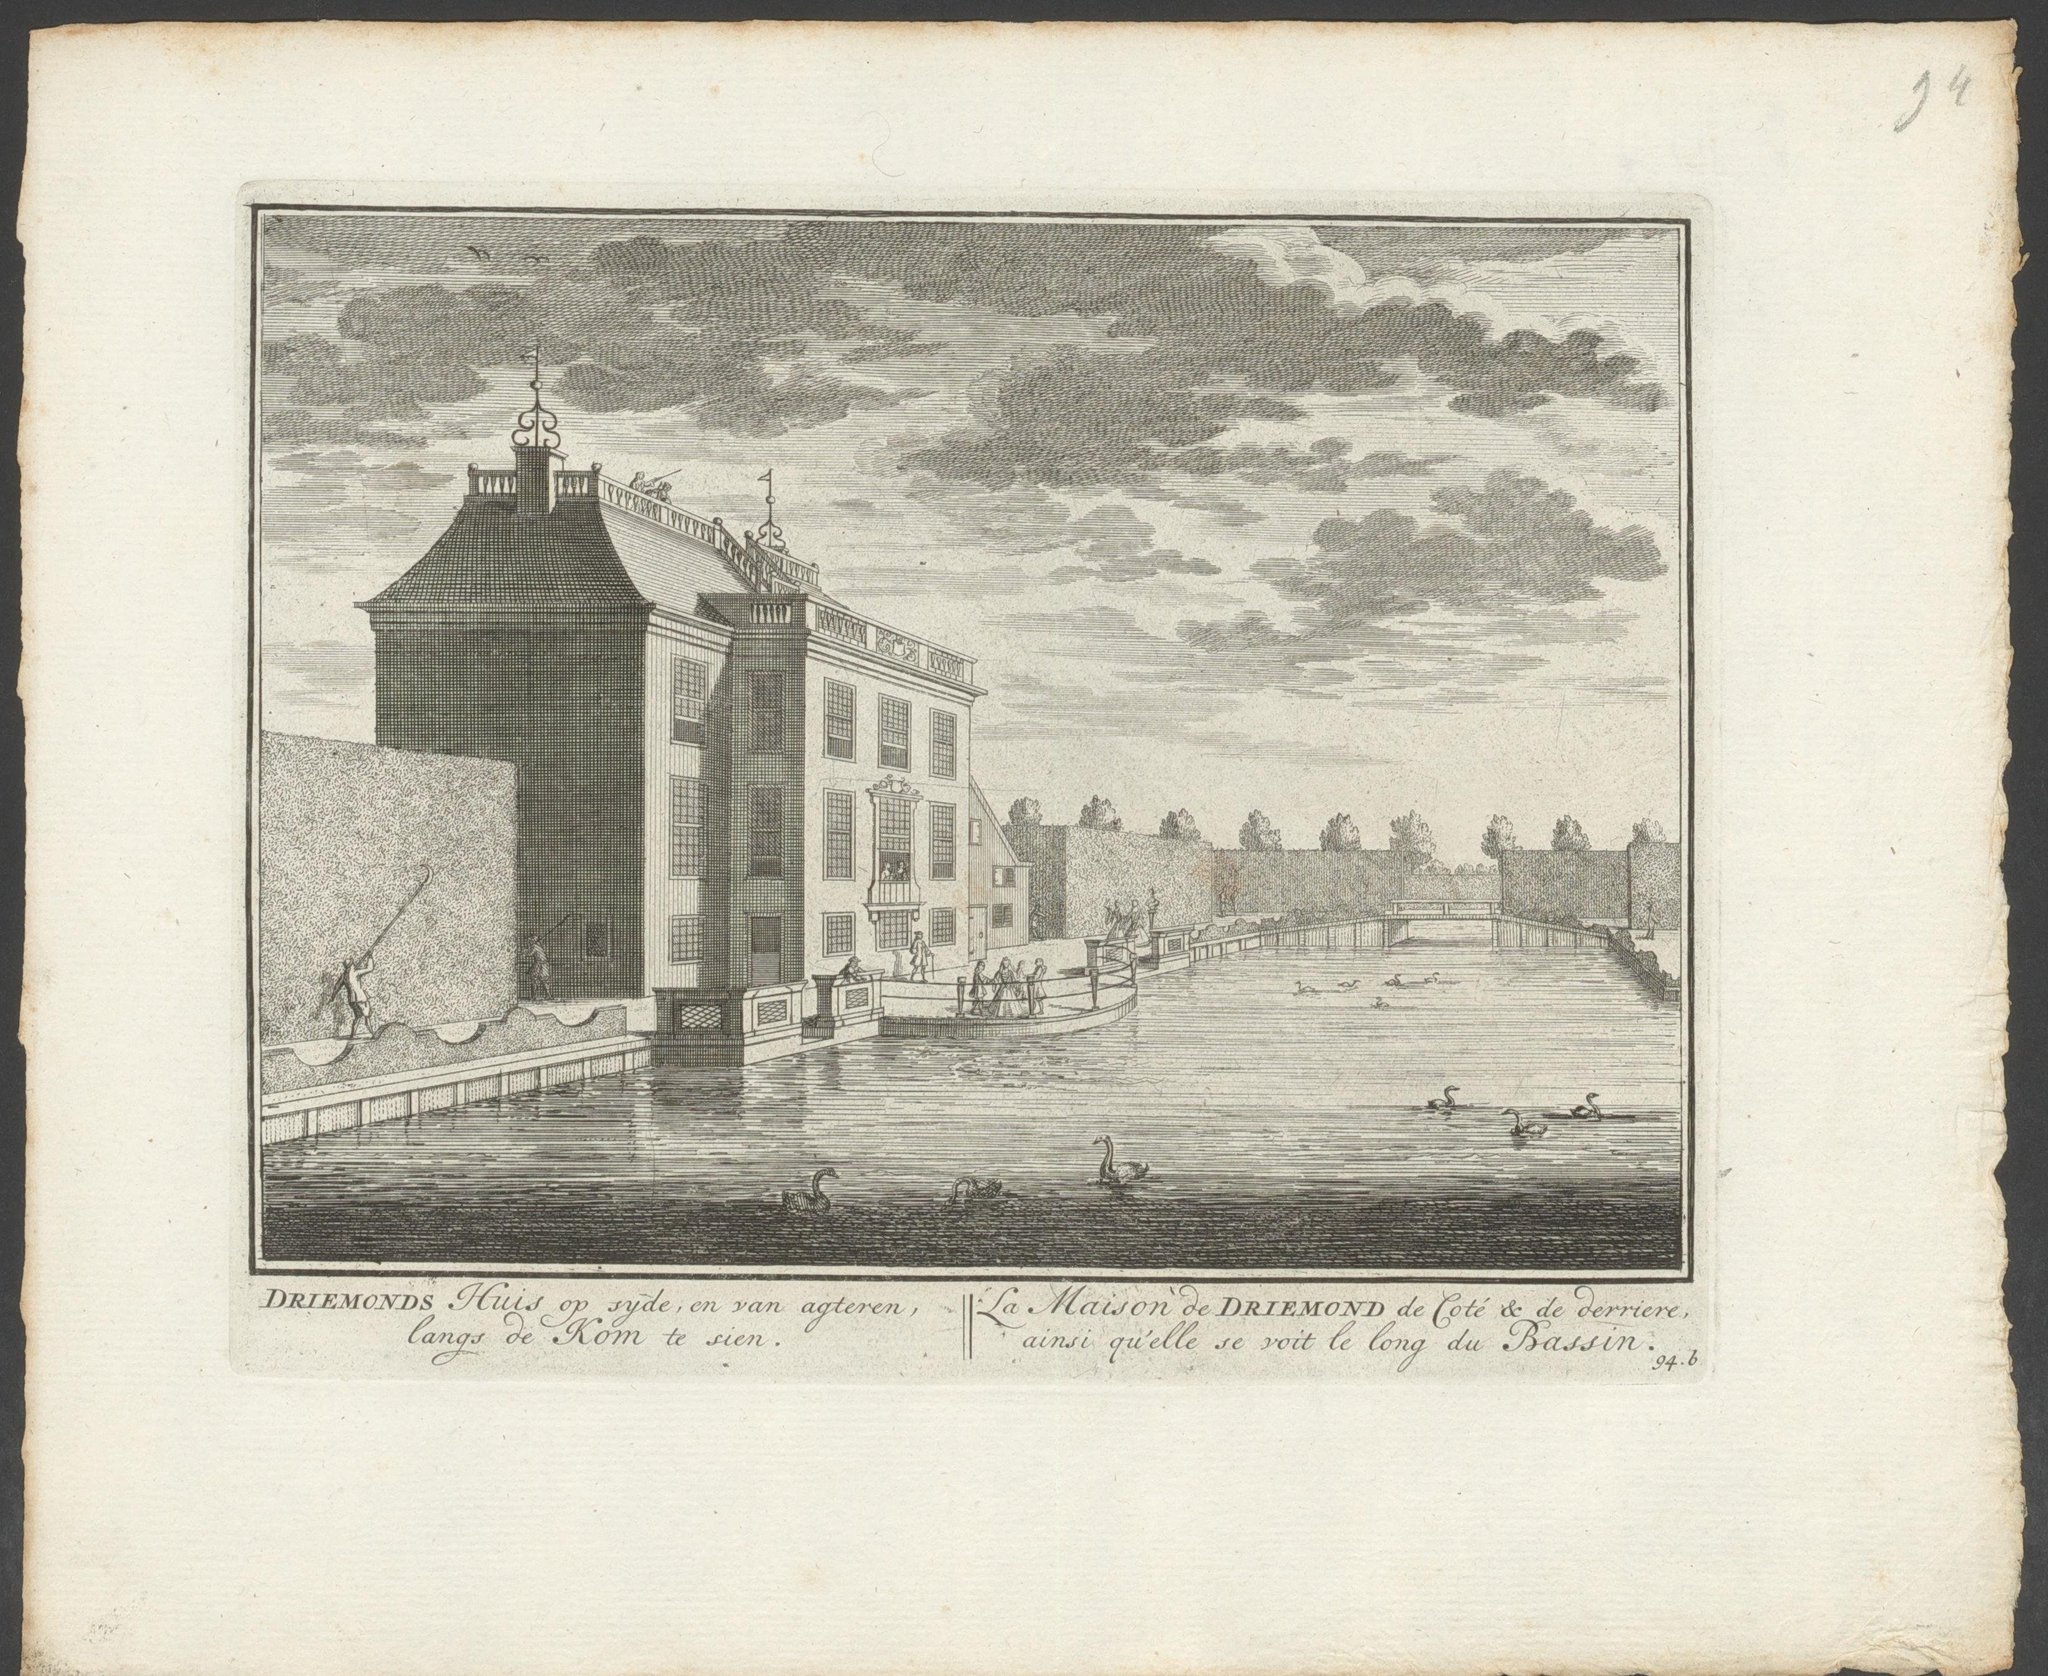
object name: print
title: Gezicht op de achterkant van de buitenplaats Driemond langs de Kom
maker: daniël stopendaal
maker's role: print maker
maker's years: 1672-1726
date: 1790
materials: paper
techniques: engraving, etching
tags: garden, country-house, amsterdam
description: Tekst in het Nederlands en het Frans in de ondermarge. Rechtsonder genummerd: 94.b. Onderwerpsrubrieken binnen de Atlas Zeden en Gewoonten: Zeden en Gewoonten in Engeren Zin, De Woning. Kastelen en buitenplaatsen. Over de Grenzen.